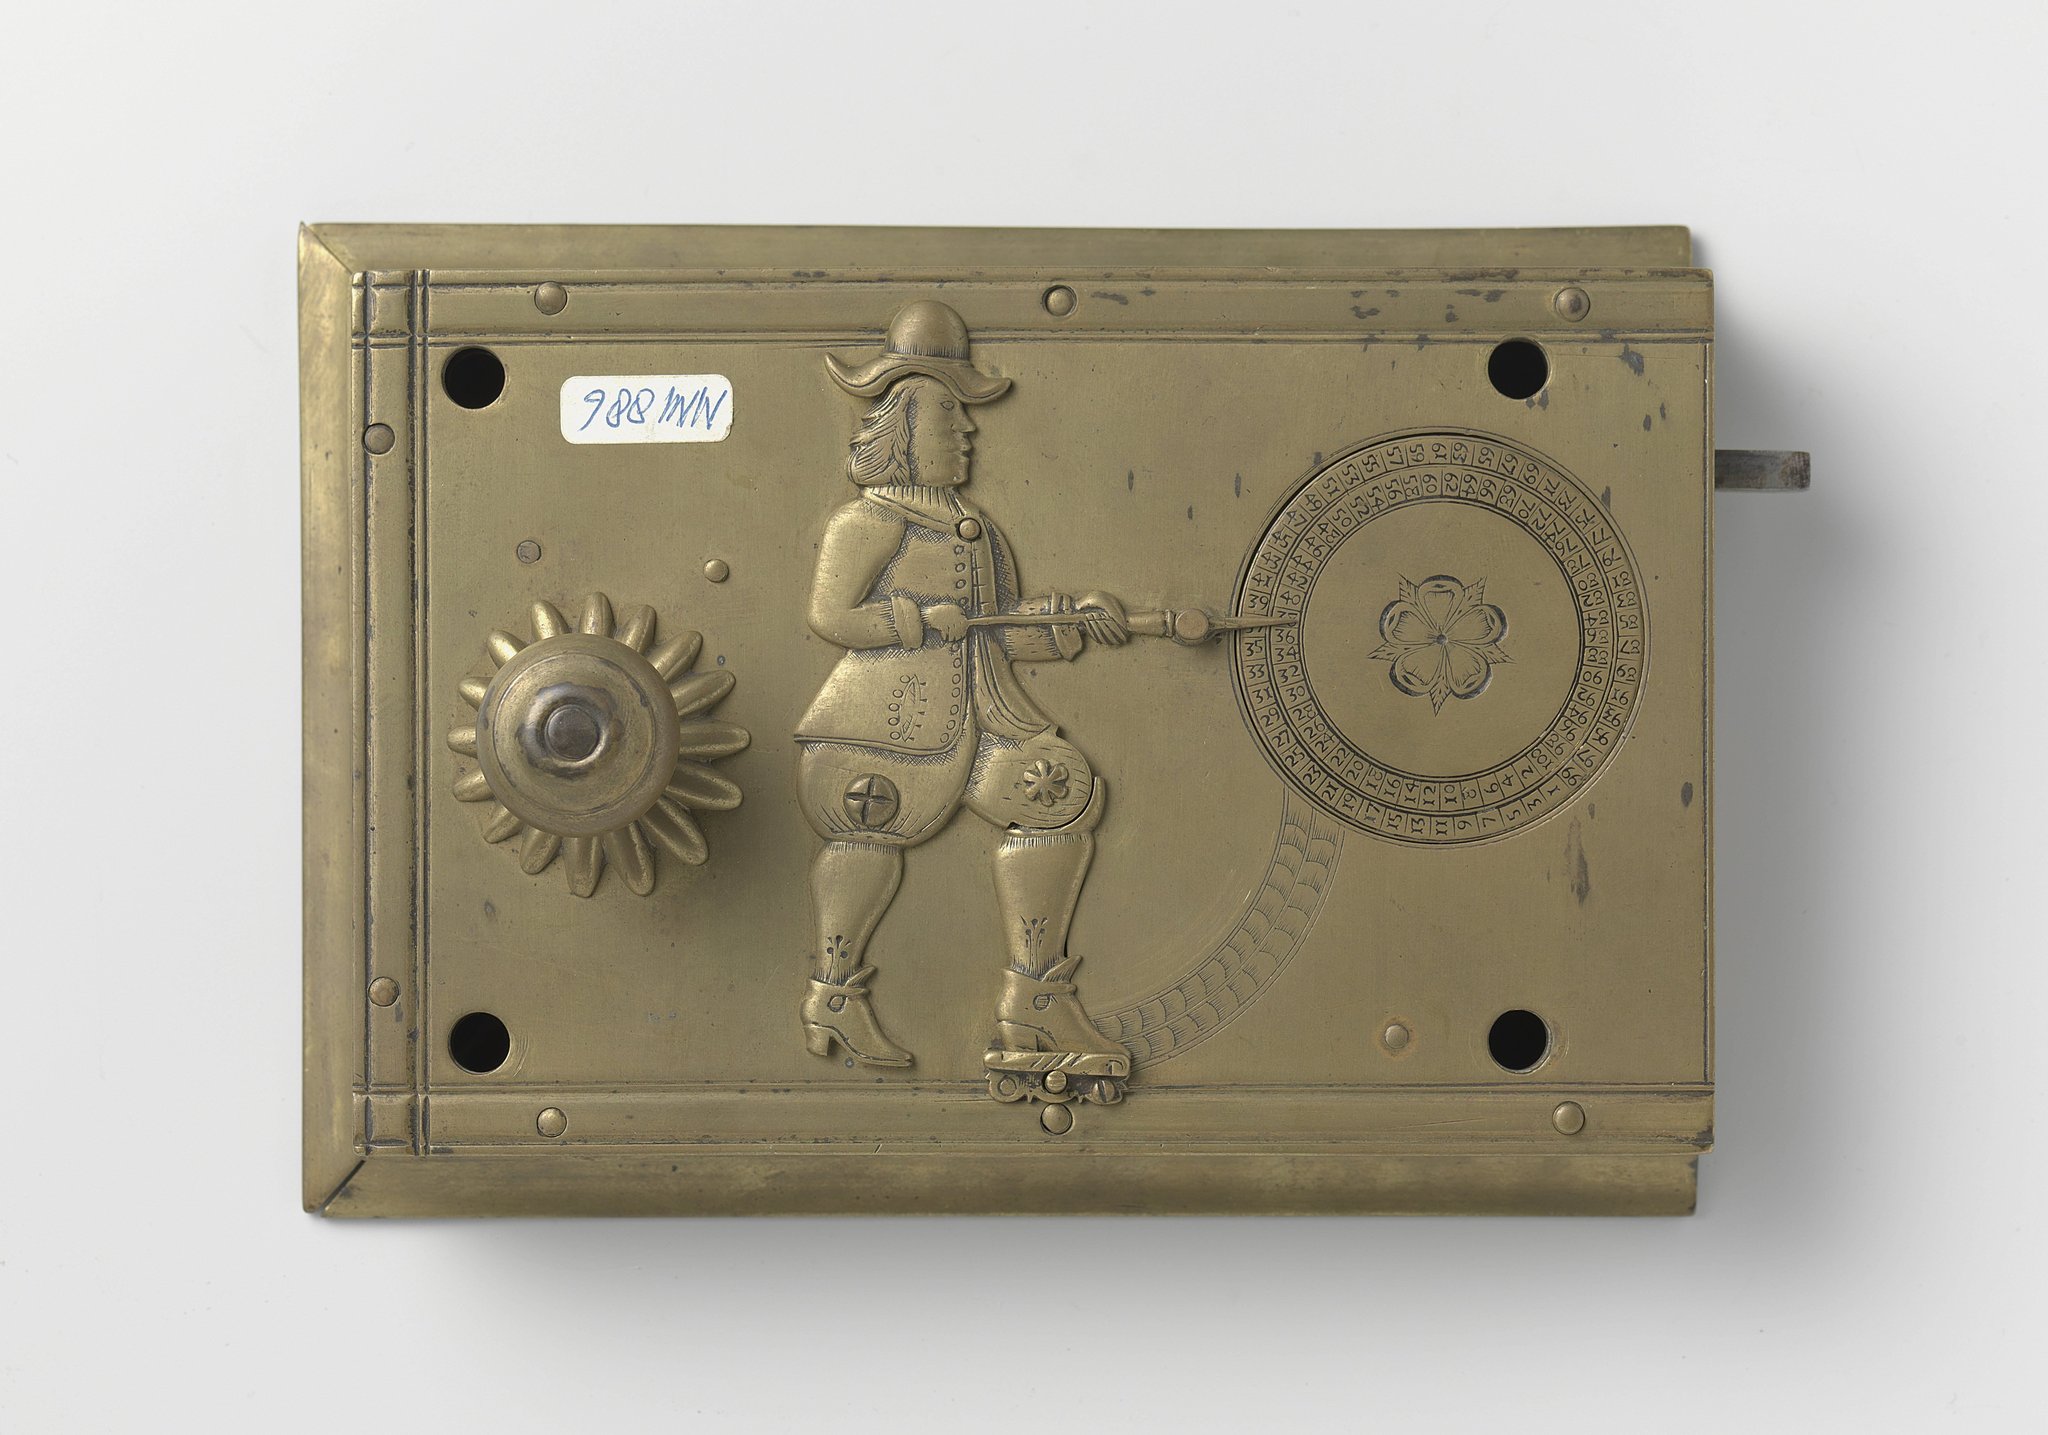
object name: tweetoerenoplegslot, tweetoerenslot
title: Detector lock with key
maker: john wilkes (slotenmaker)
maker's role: slotenmaker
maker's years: -1733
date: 1675-1700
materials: brass, iron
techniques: casting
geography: birmingham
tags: the hague, berlin, william i of the netherlands, standing figure (+ sideview, profile), head-gear: hat (+ men's clothes)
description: The keyhole for this lock is concealed behind the man’s left leg. The lock opens and closes when the key is turned twice. With two complete turns of the key, the dial at which the man’s stick is pointing rotates. This records how often the lock has been opened. The doorknob is released when the man’s hat is pushed aside.